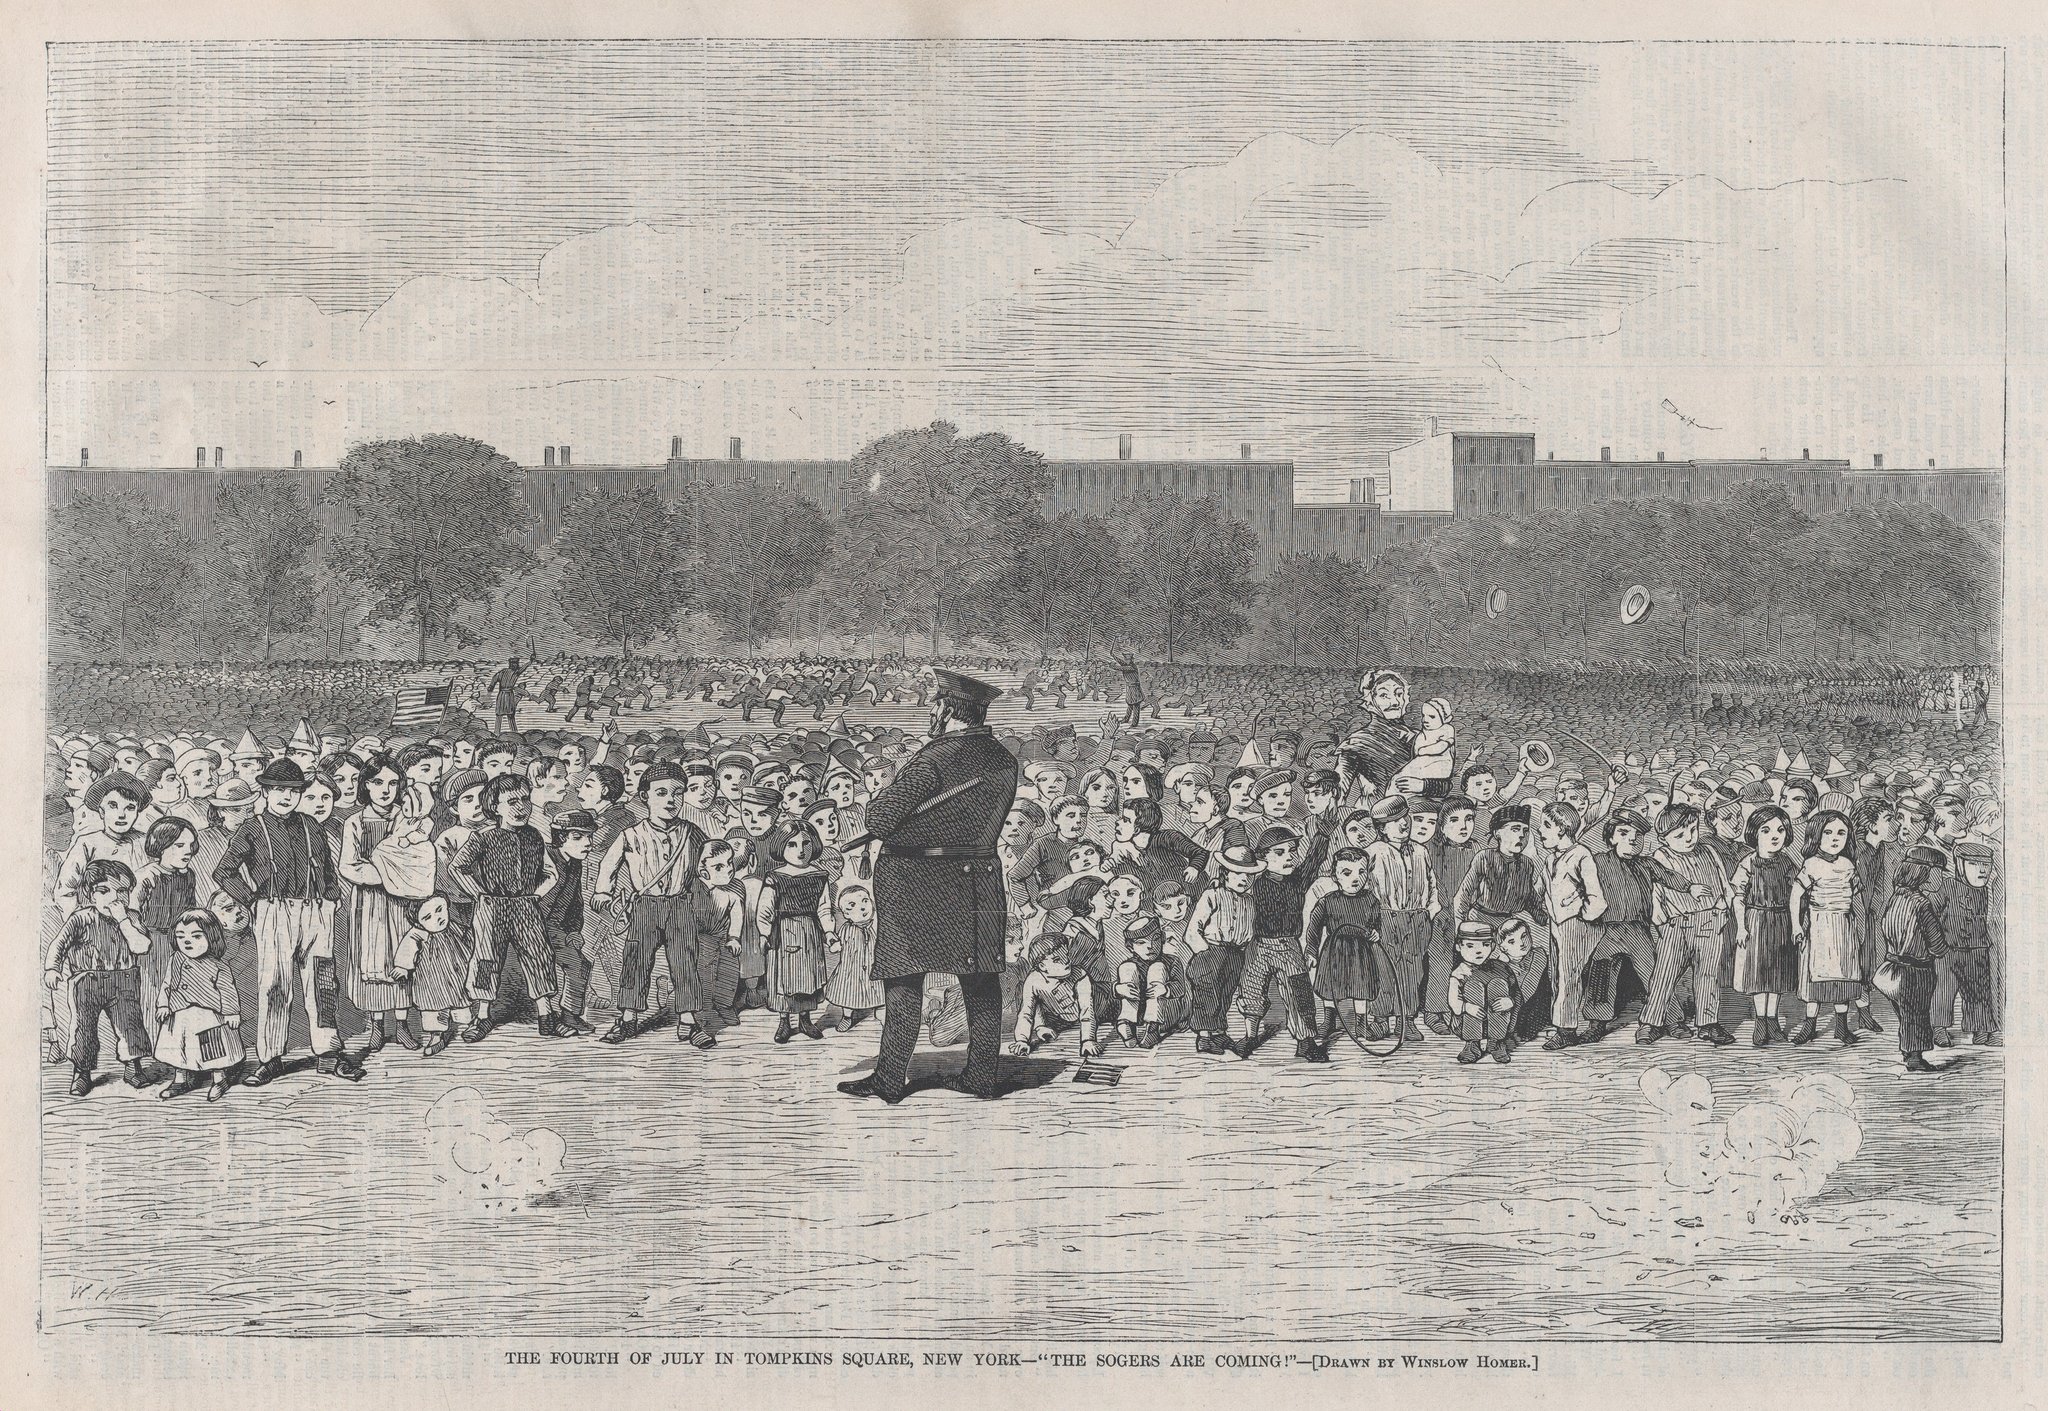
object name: print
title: The Fourth of July in Tompkins Square, New York – "The Sogers Are Coming" (from "Harper's Bazar: A Repository of Fashion, Pleasure and Instruction," Vol. I)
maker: winslow homer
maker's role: artist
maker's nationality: american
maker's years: 1836-1910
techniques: engraving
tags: crowd